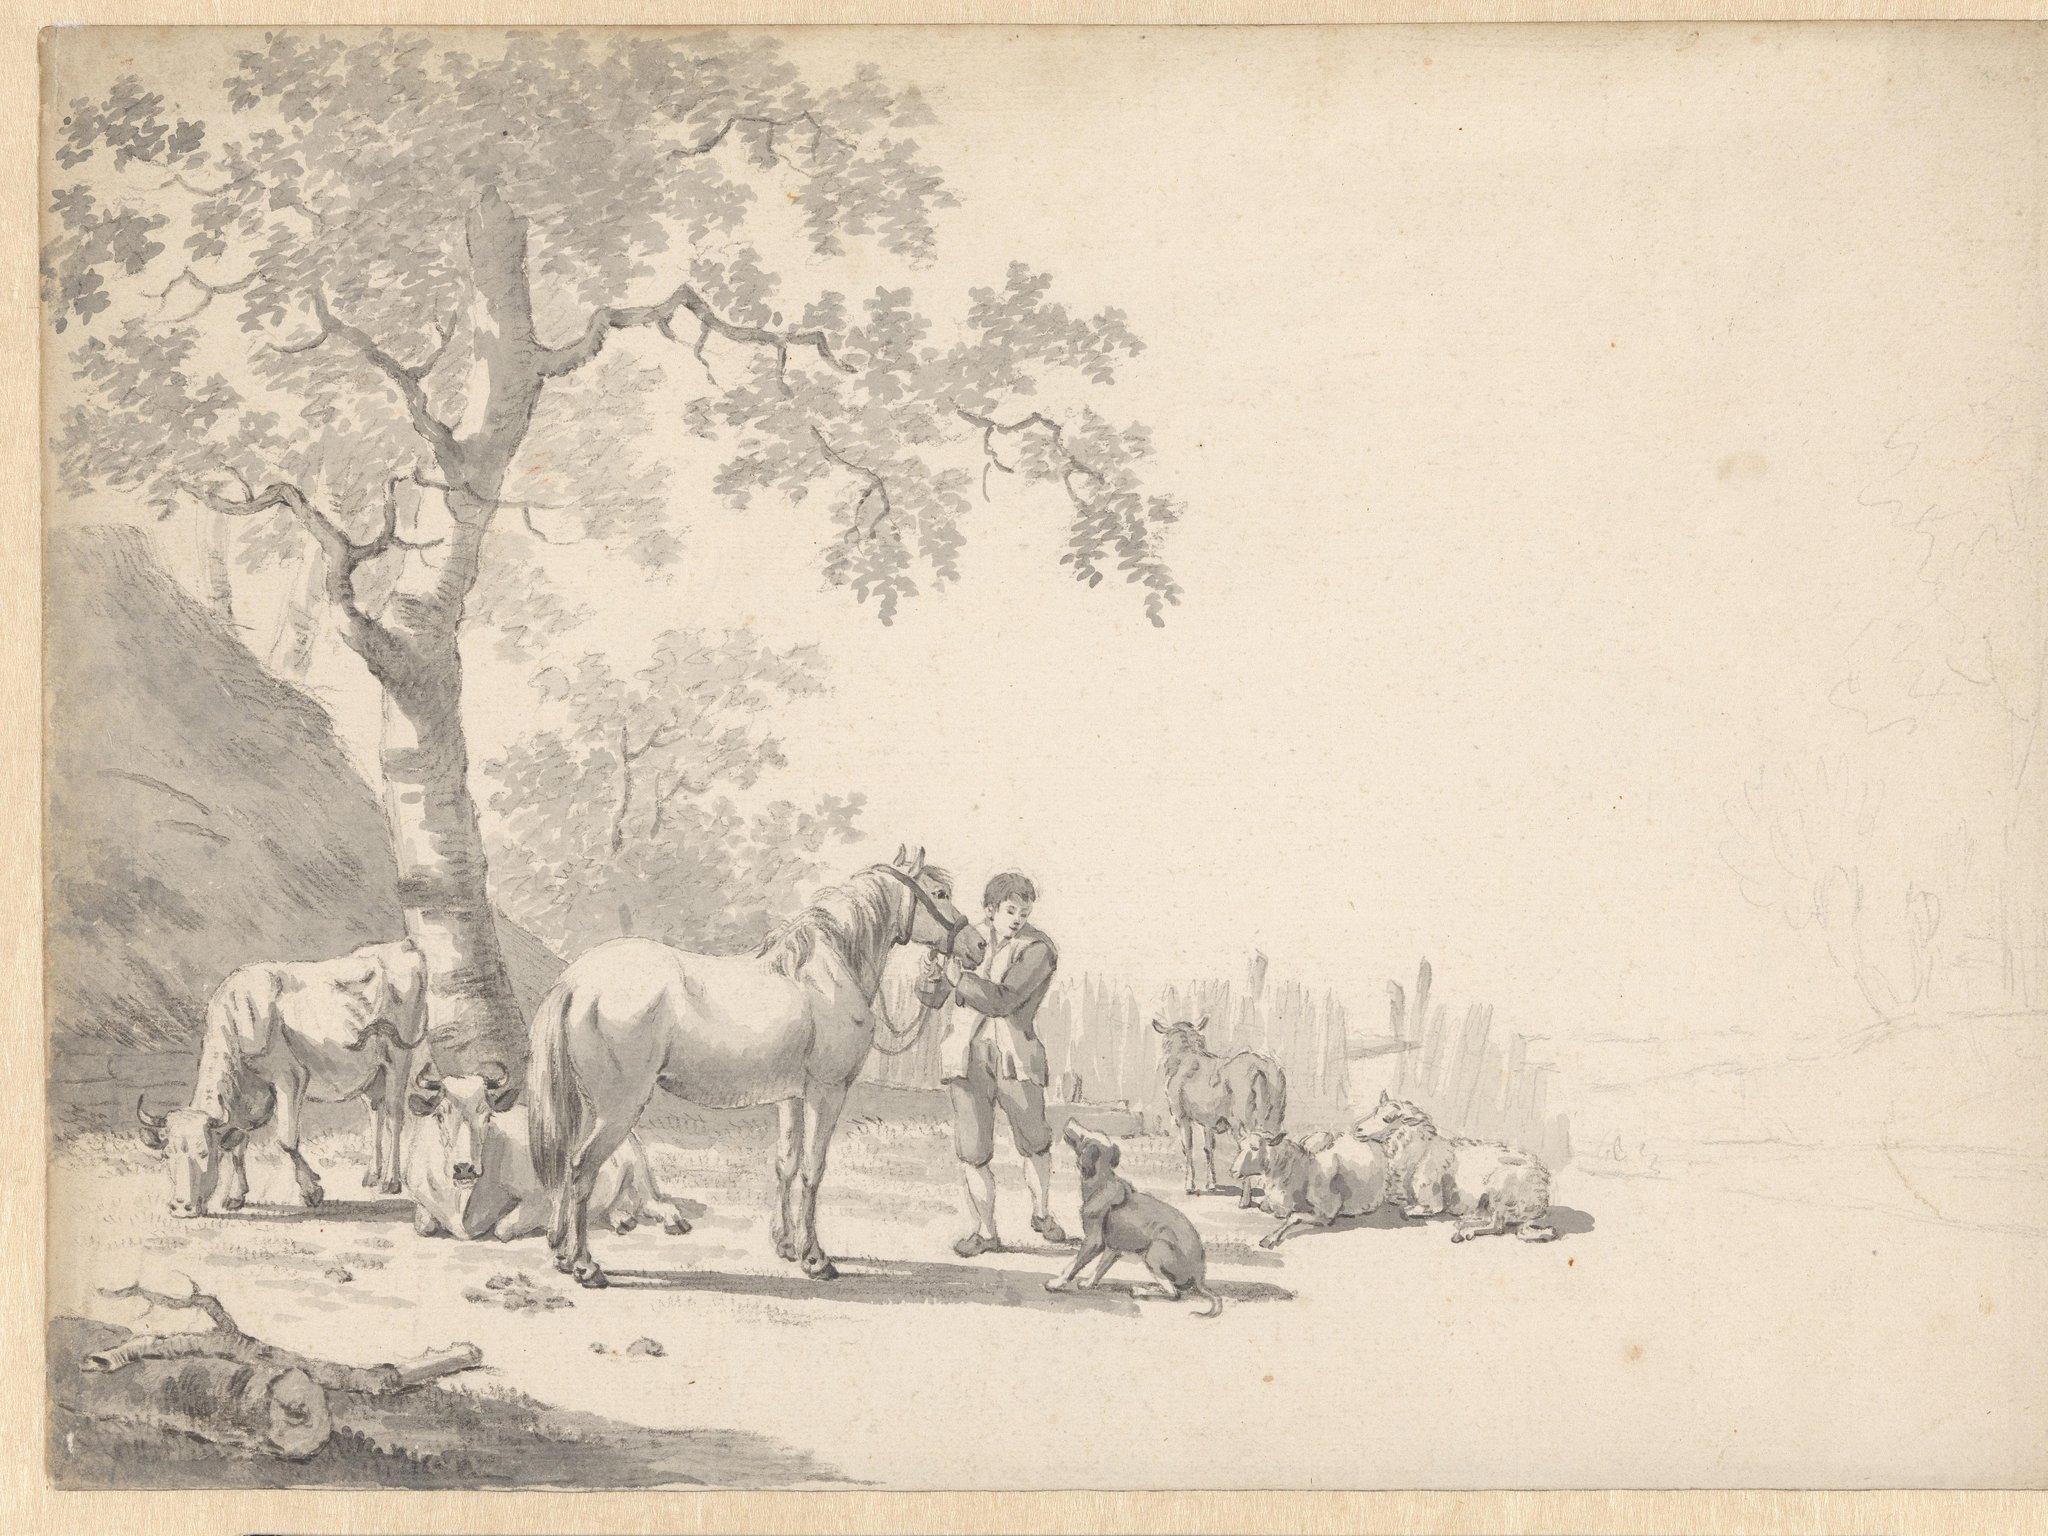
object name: drawing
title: Jongeman met paard en hond tussen ander rustend vee onder boom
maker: Anonymous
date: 1800-1900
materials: chalk, paper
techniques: brush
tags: cattle